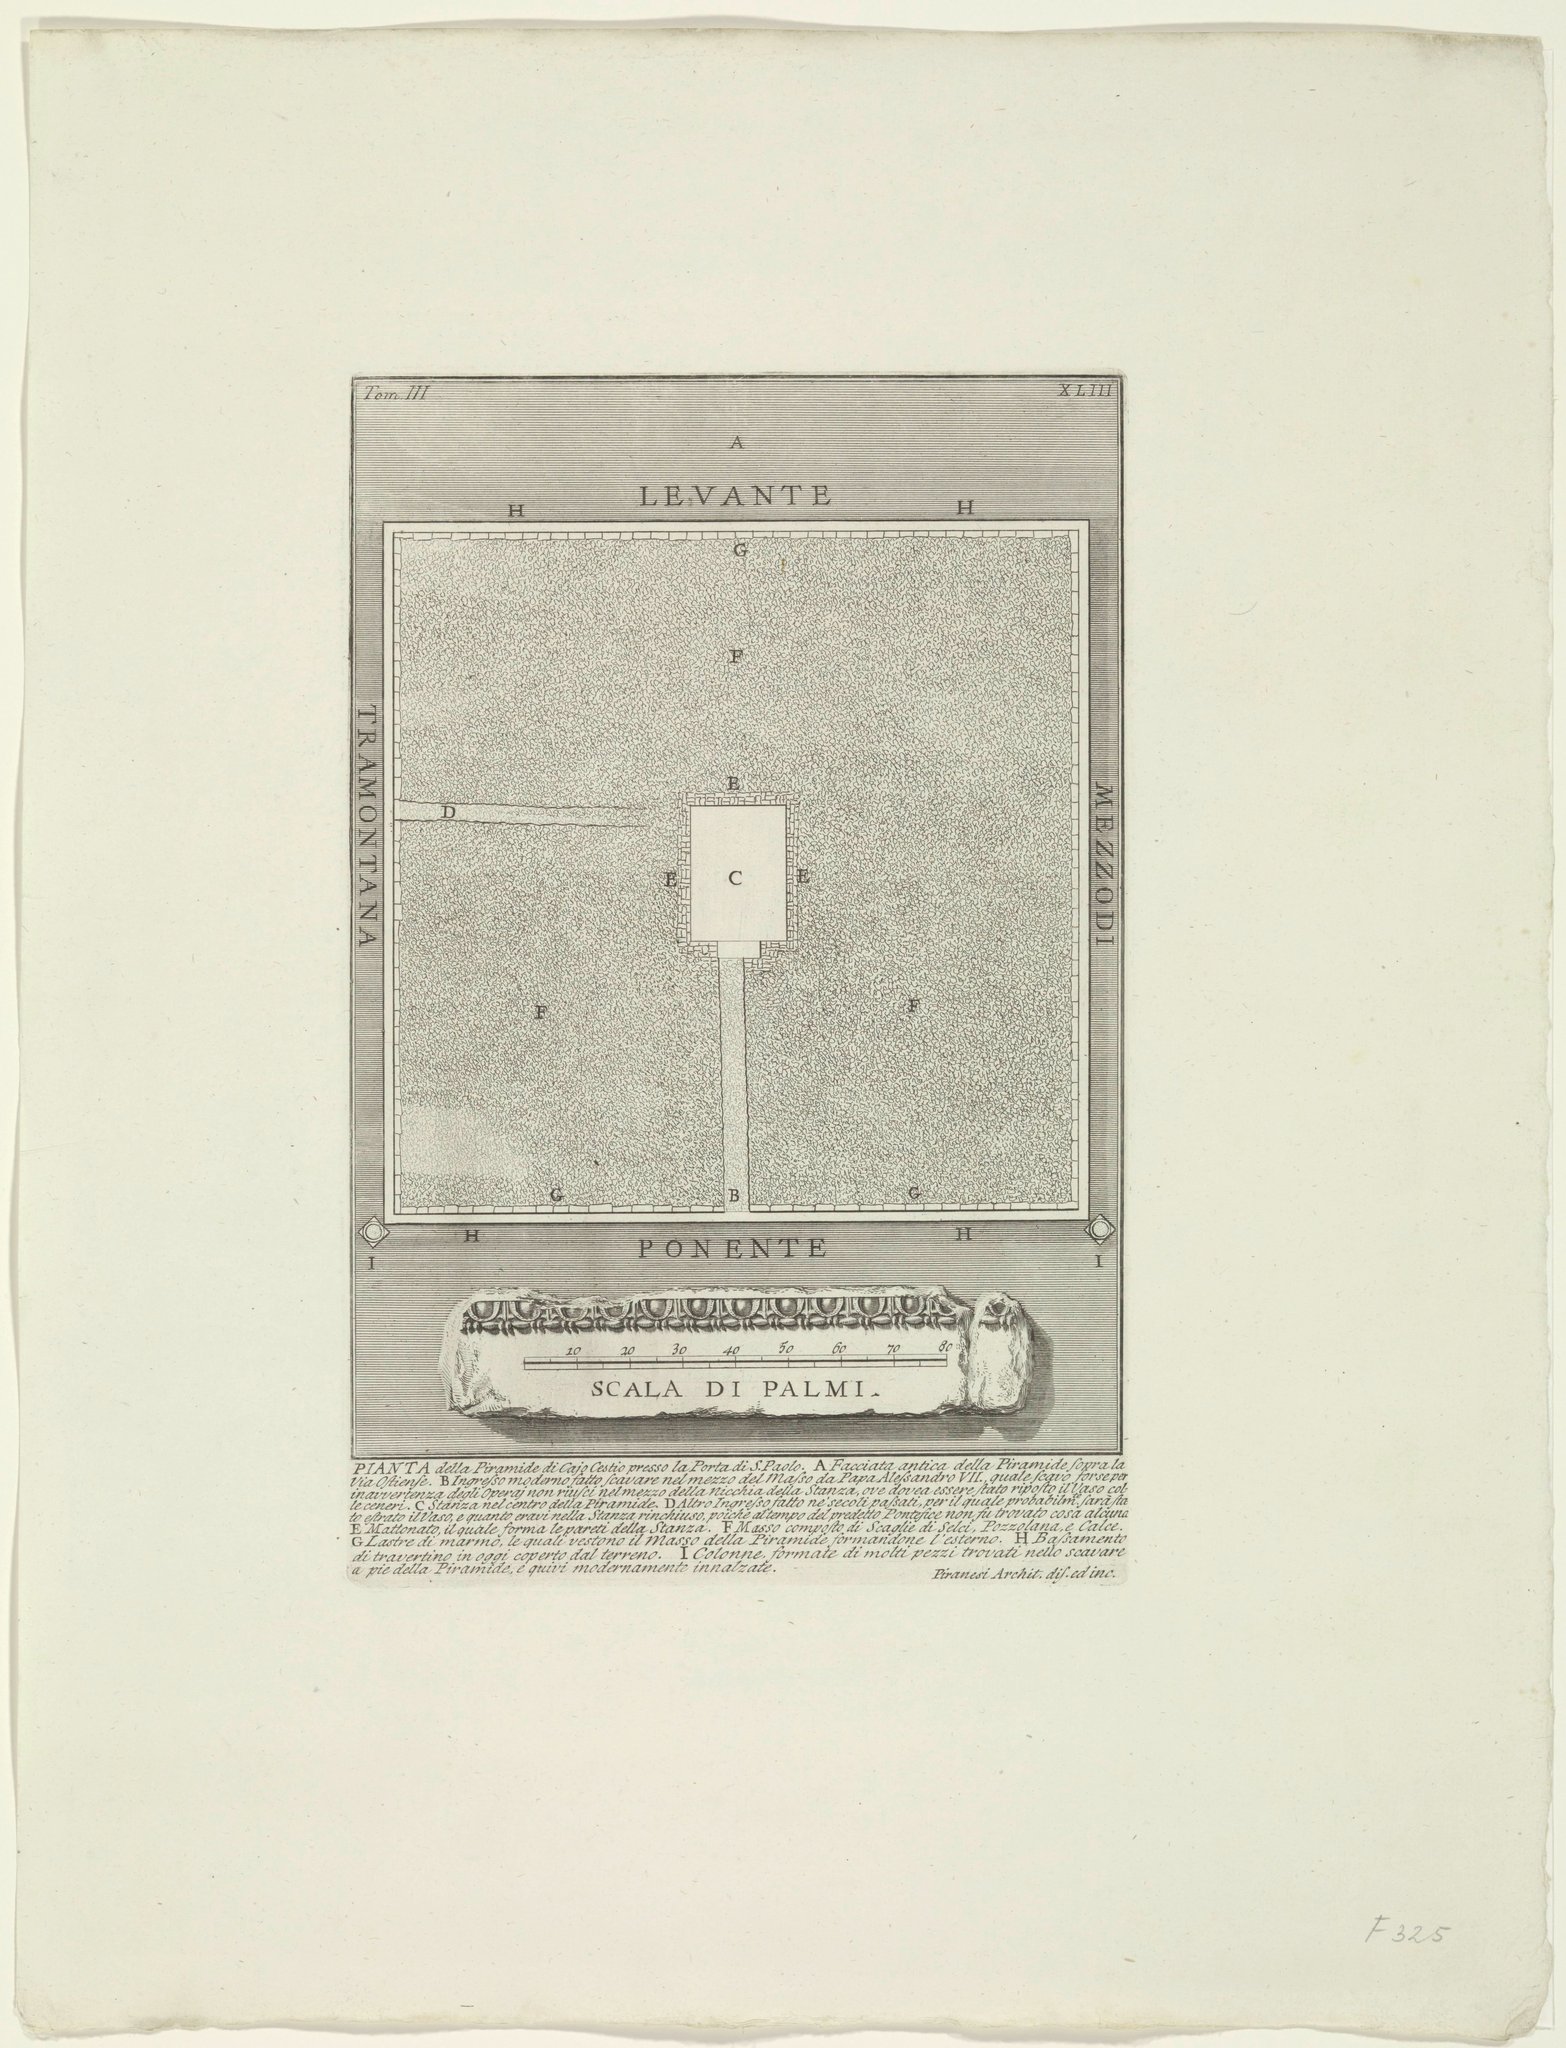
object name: print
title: Le Antichità Romane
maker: giovanni battista piranesi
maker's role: designer, draughtsman, print maker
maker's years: 1720-1778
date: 1756-1757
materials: paper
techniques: etching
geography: rome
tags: pyramid (marking grave), plan ~ architecture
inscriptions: collector's mark: Lugt 2228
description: Deze prent maakt deel uit van de serie 'Le Antichità Romane'. Piranesi deed meer dan acht jaar voorstudie voor deze 250 platen tellende serie die in vier volumes werd uitgegeven. Hij produceerde de prenten tussen ca. 1756 en 1757. De serie bevat ook prenten door of naar andere prentmakers, onder wie Francesco Bianchini en Girolamo Rossi.